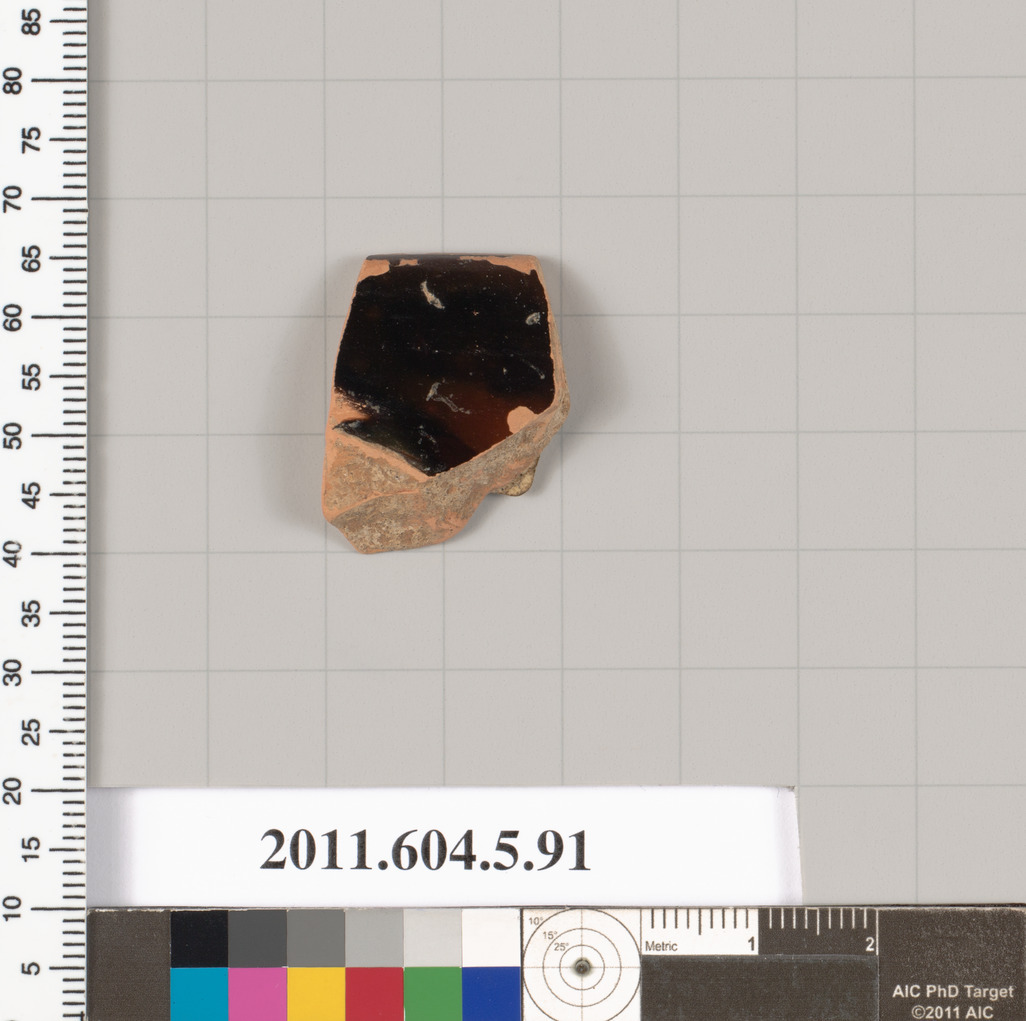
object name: kylix fragment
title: Terracotta rim fragment of a kylix (drinking cup)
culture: greek, attic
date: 500-480 BCE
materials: terracotta